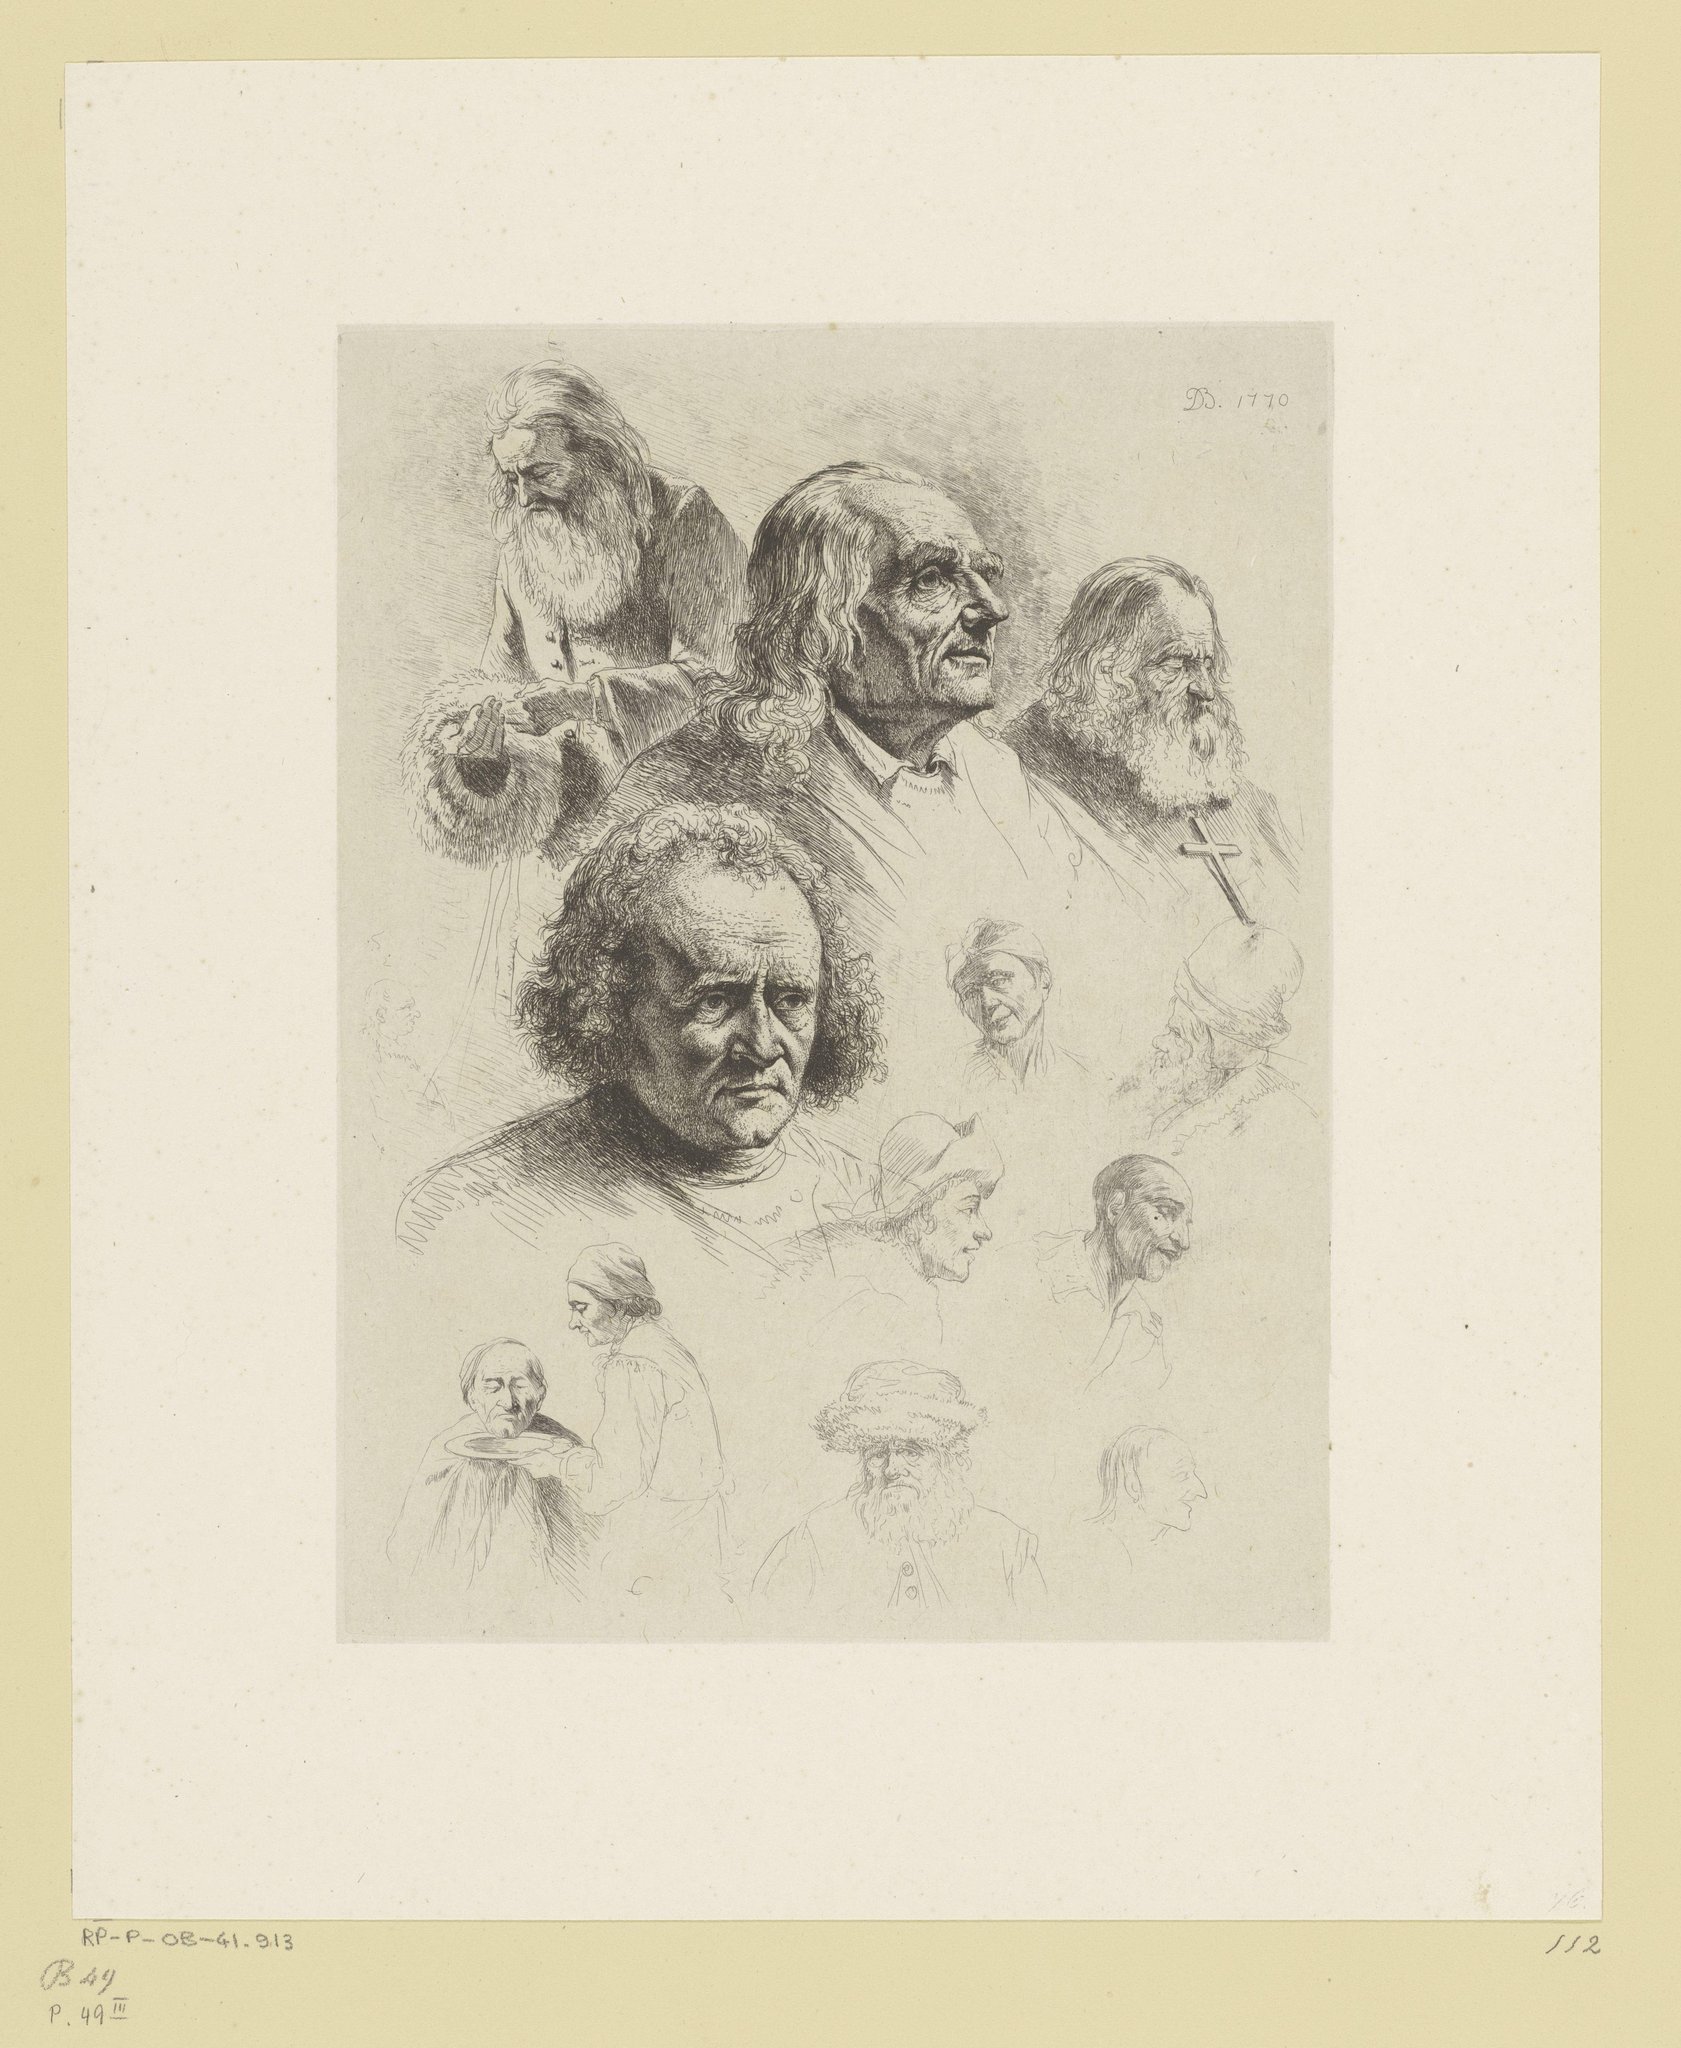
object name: print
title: Compositie met dertien hoofden van mannen van verschillende leeftijden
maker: jean jacques de boissieu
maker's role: draughtsman, print maker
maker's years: 1736-1810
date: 1770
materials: paper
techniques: etching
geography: france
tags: head (human), old man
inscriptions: collector's mark: Lugt 12